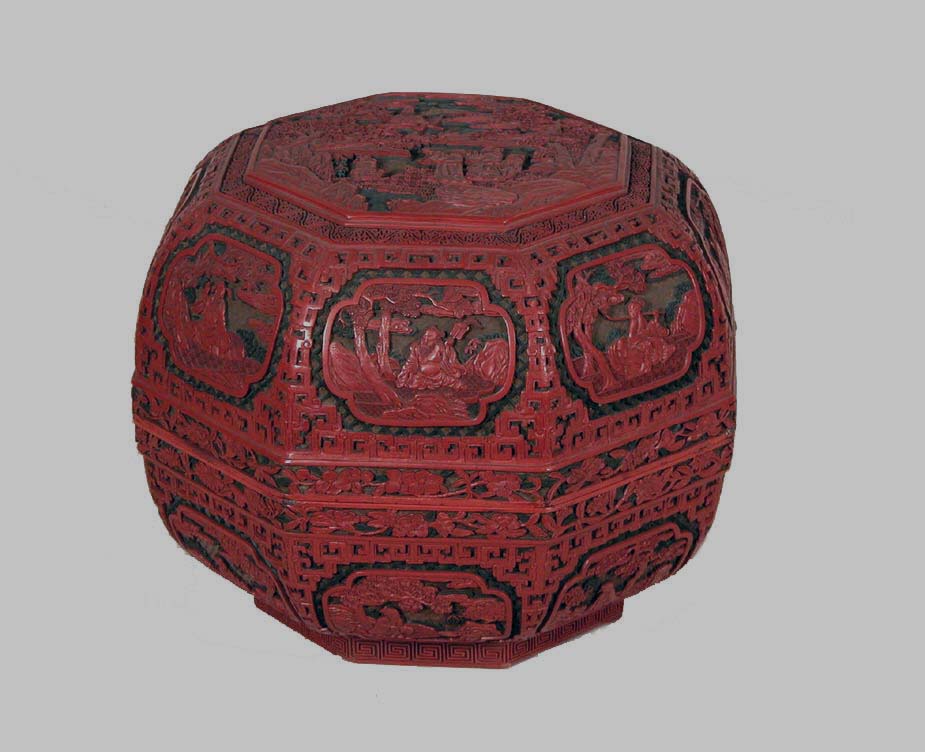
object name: box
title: Box with Daoists welcoming immortal Shoulao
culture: chinese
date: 1801-1900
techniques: carving